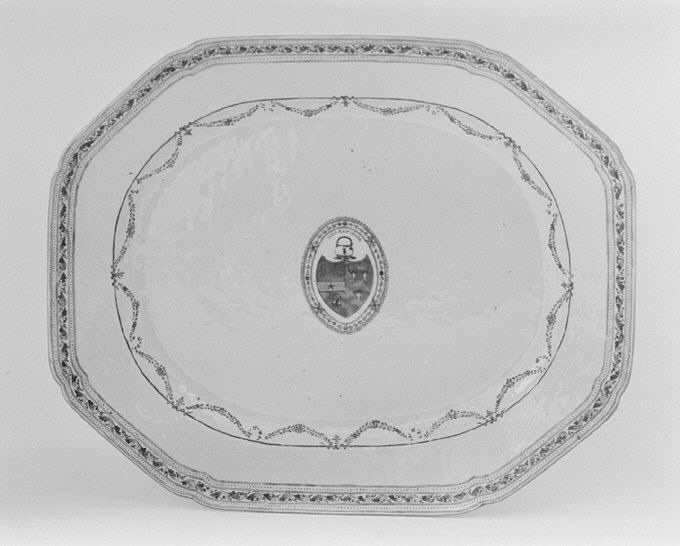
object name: platter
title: Platter (part of a service)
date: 1770-1785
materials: hard paste porcelain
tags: coat of arms